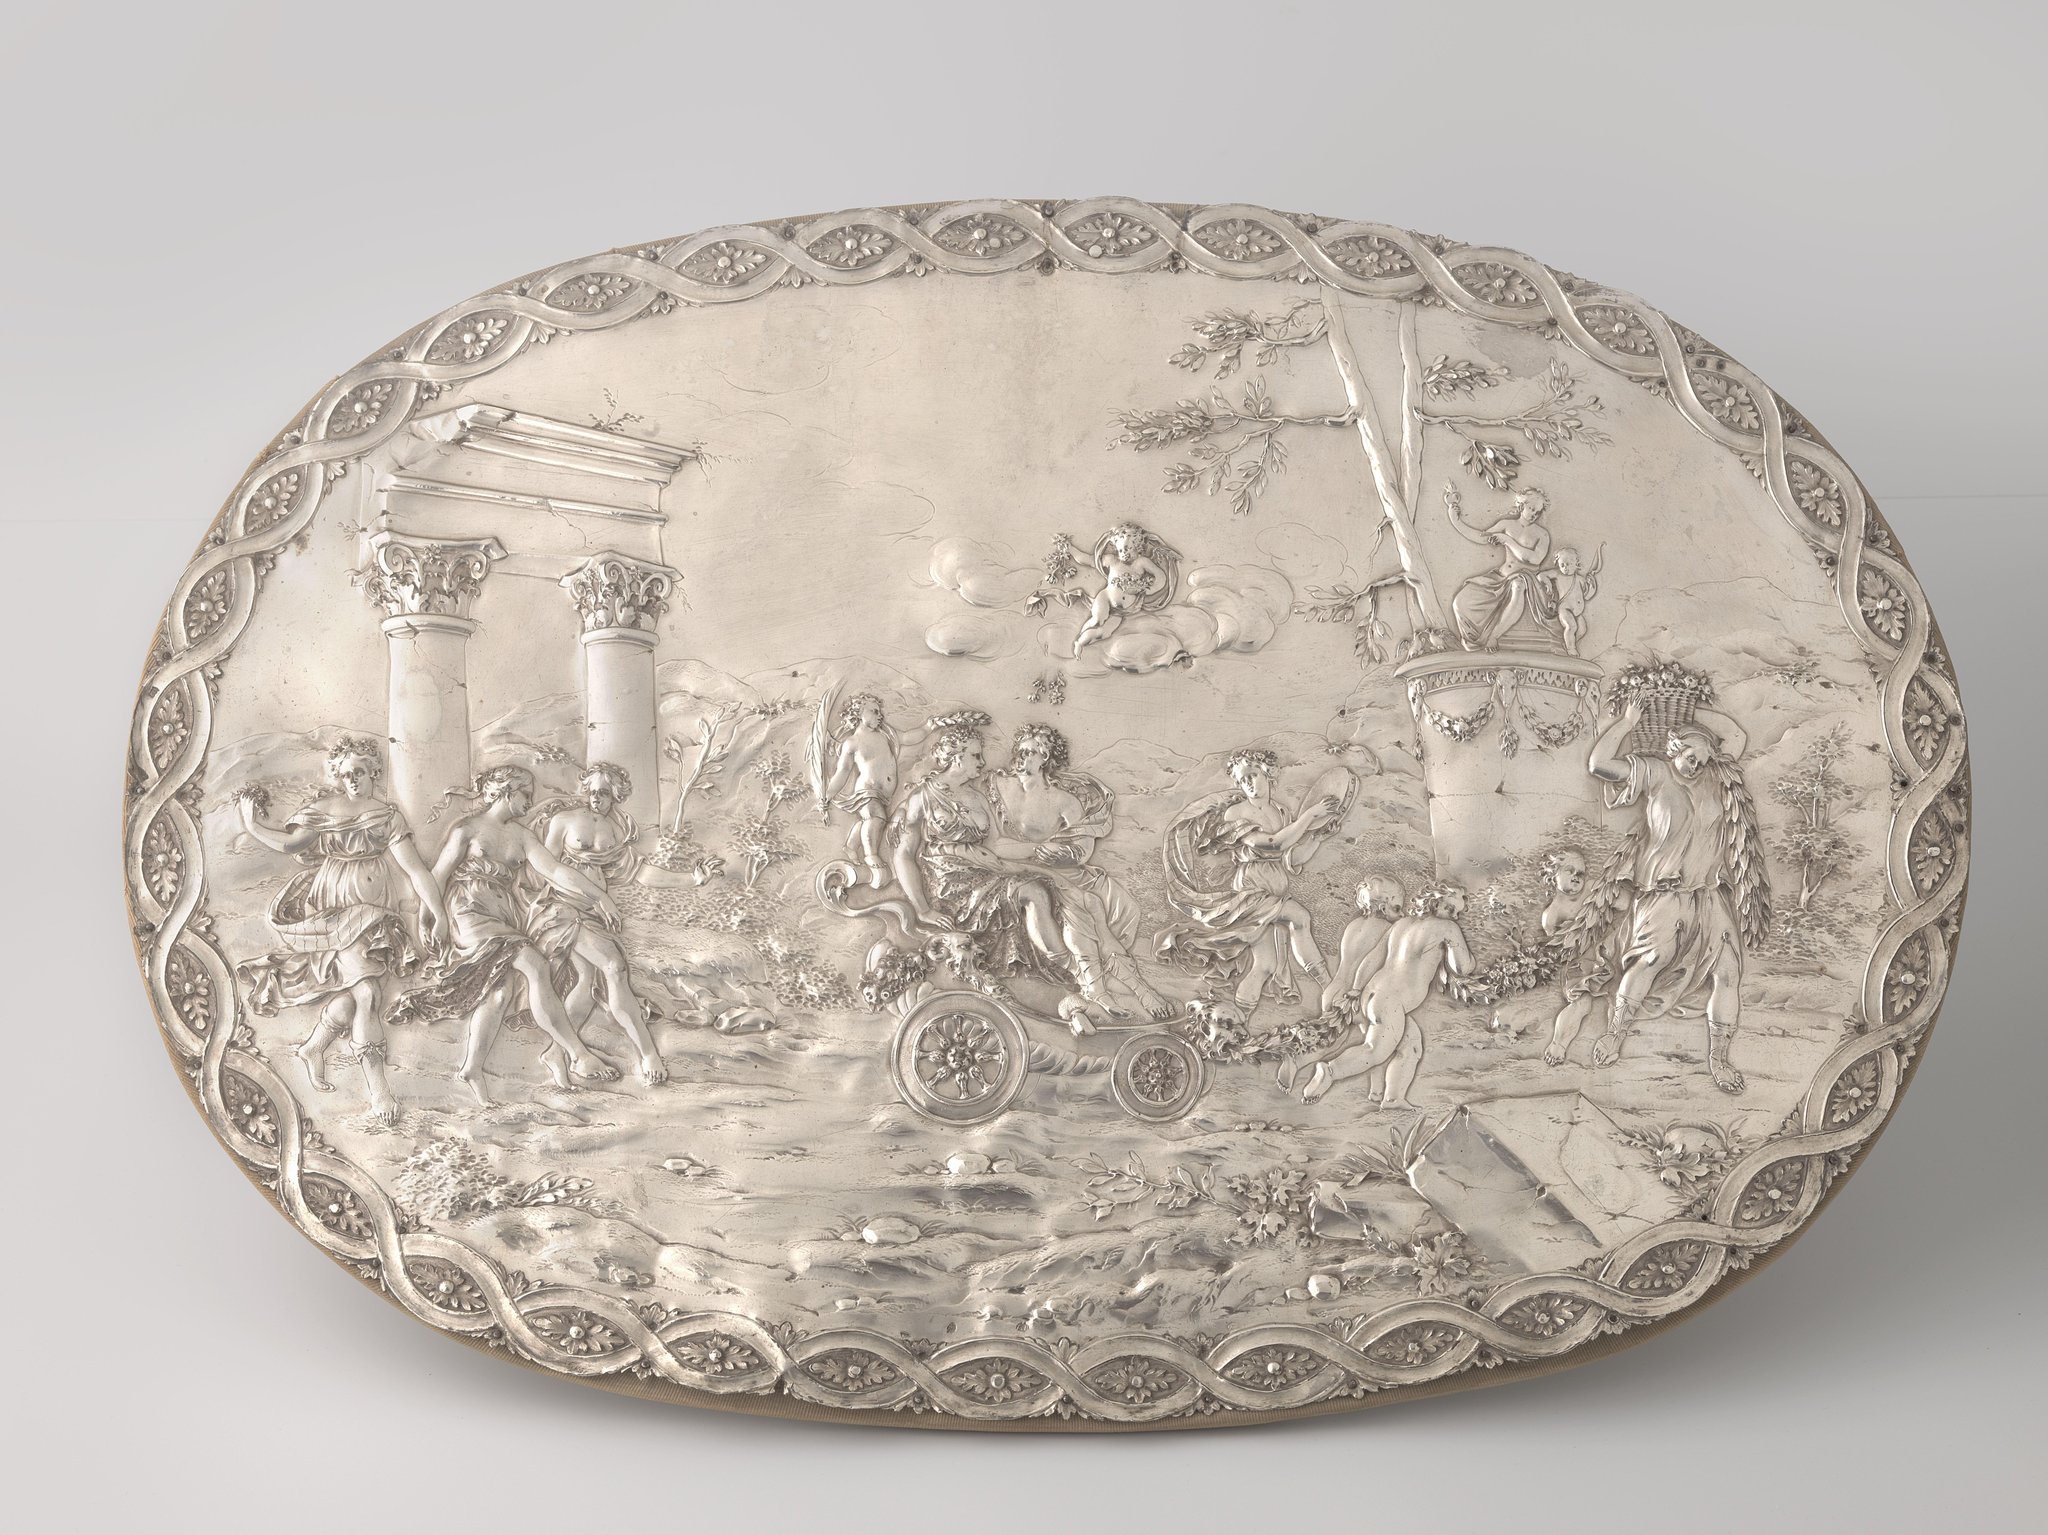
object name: plaque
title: Triomf van de liefde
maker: albrecht biller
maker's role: plaquettemaker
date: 1700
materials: silver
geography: augsburg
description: Groot ovaal reliëf, omgeven door een dubbel geslingerde rand, waarin rozetten. oorspronkelijk het middenstuk van een met zilver beslagen tafel. Op een schelpvormige zegewagen is een liefdespaar gezeten, voortgetrokken aan festoenen door een vrouw en drie knaapjes. De geliefde wordt door een achter haar staande putto, die een palmtak draagt gekroond, terwijl een zwevende putto de man met bloemen bestrooit. Naast hem een figuur met tamboerijn. Achter de wagen drie dansende vrouwen voor een tempelfragment. rechts op een piedestal Venus en Amor.